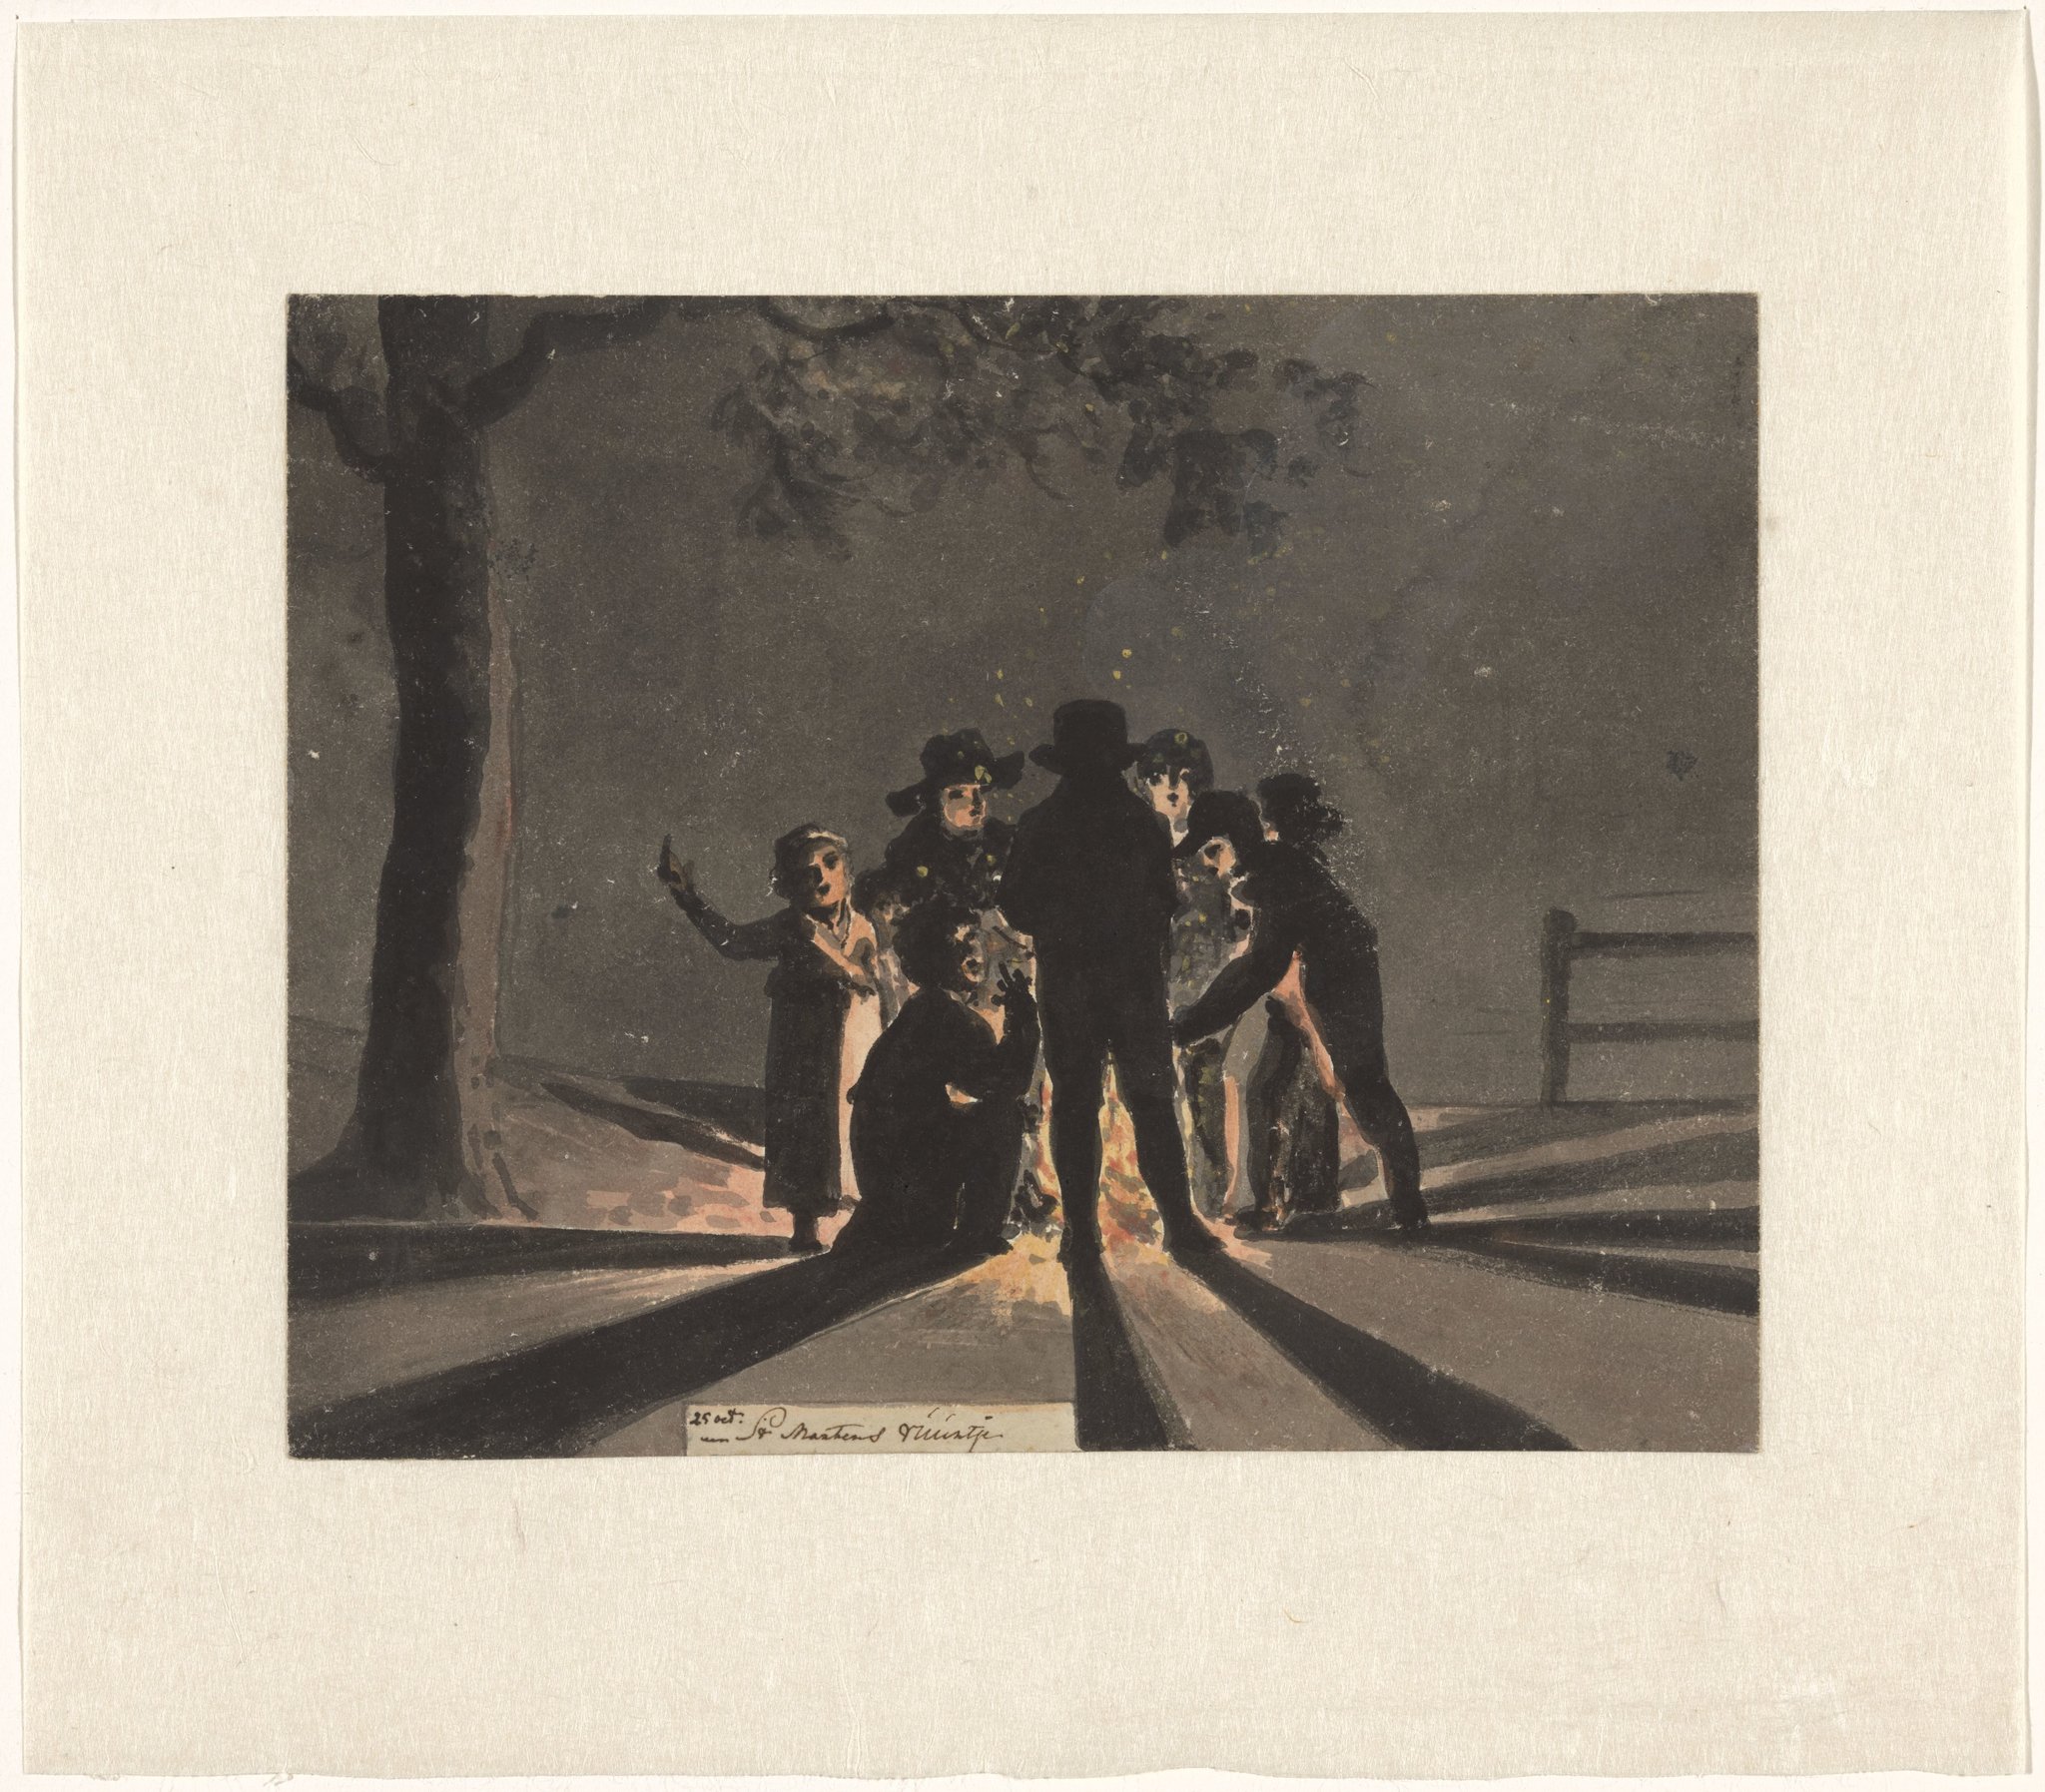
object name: drawing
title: Children clustered around a Saint Martin’s bonfire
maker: christiaan andriessen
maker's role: draughtsman, print maker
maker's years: 1775-1846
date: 1805-1808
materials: paper, watercolor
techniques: pen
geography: amsterdam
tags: children's games and plays, st. martin's day (november 11), bonfire, fire-works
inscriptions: inscription, collector's mark: Lugt 4618